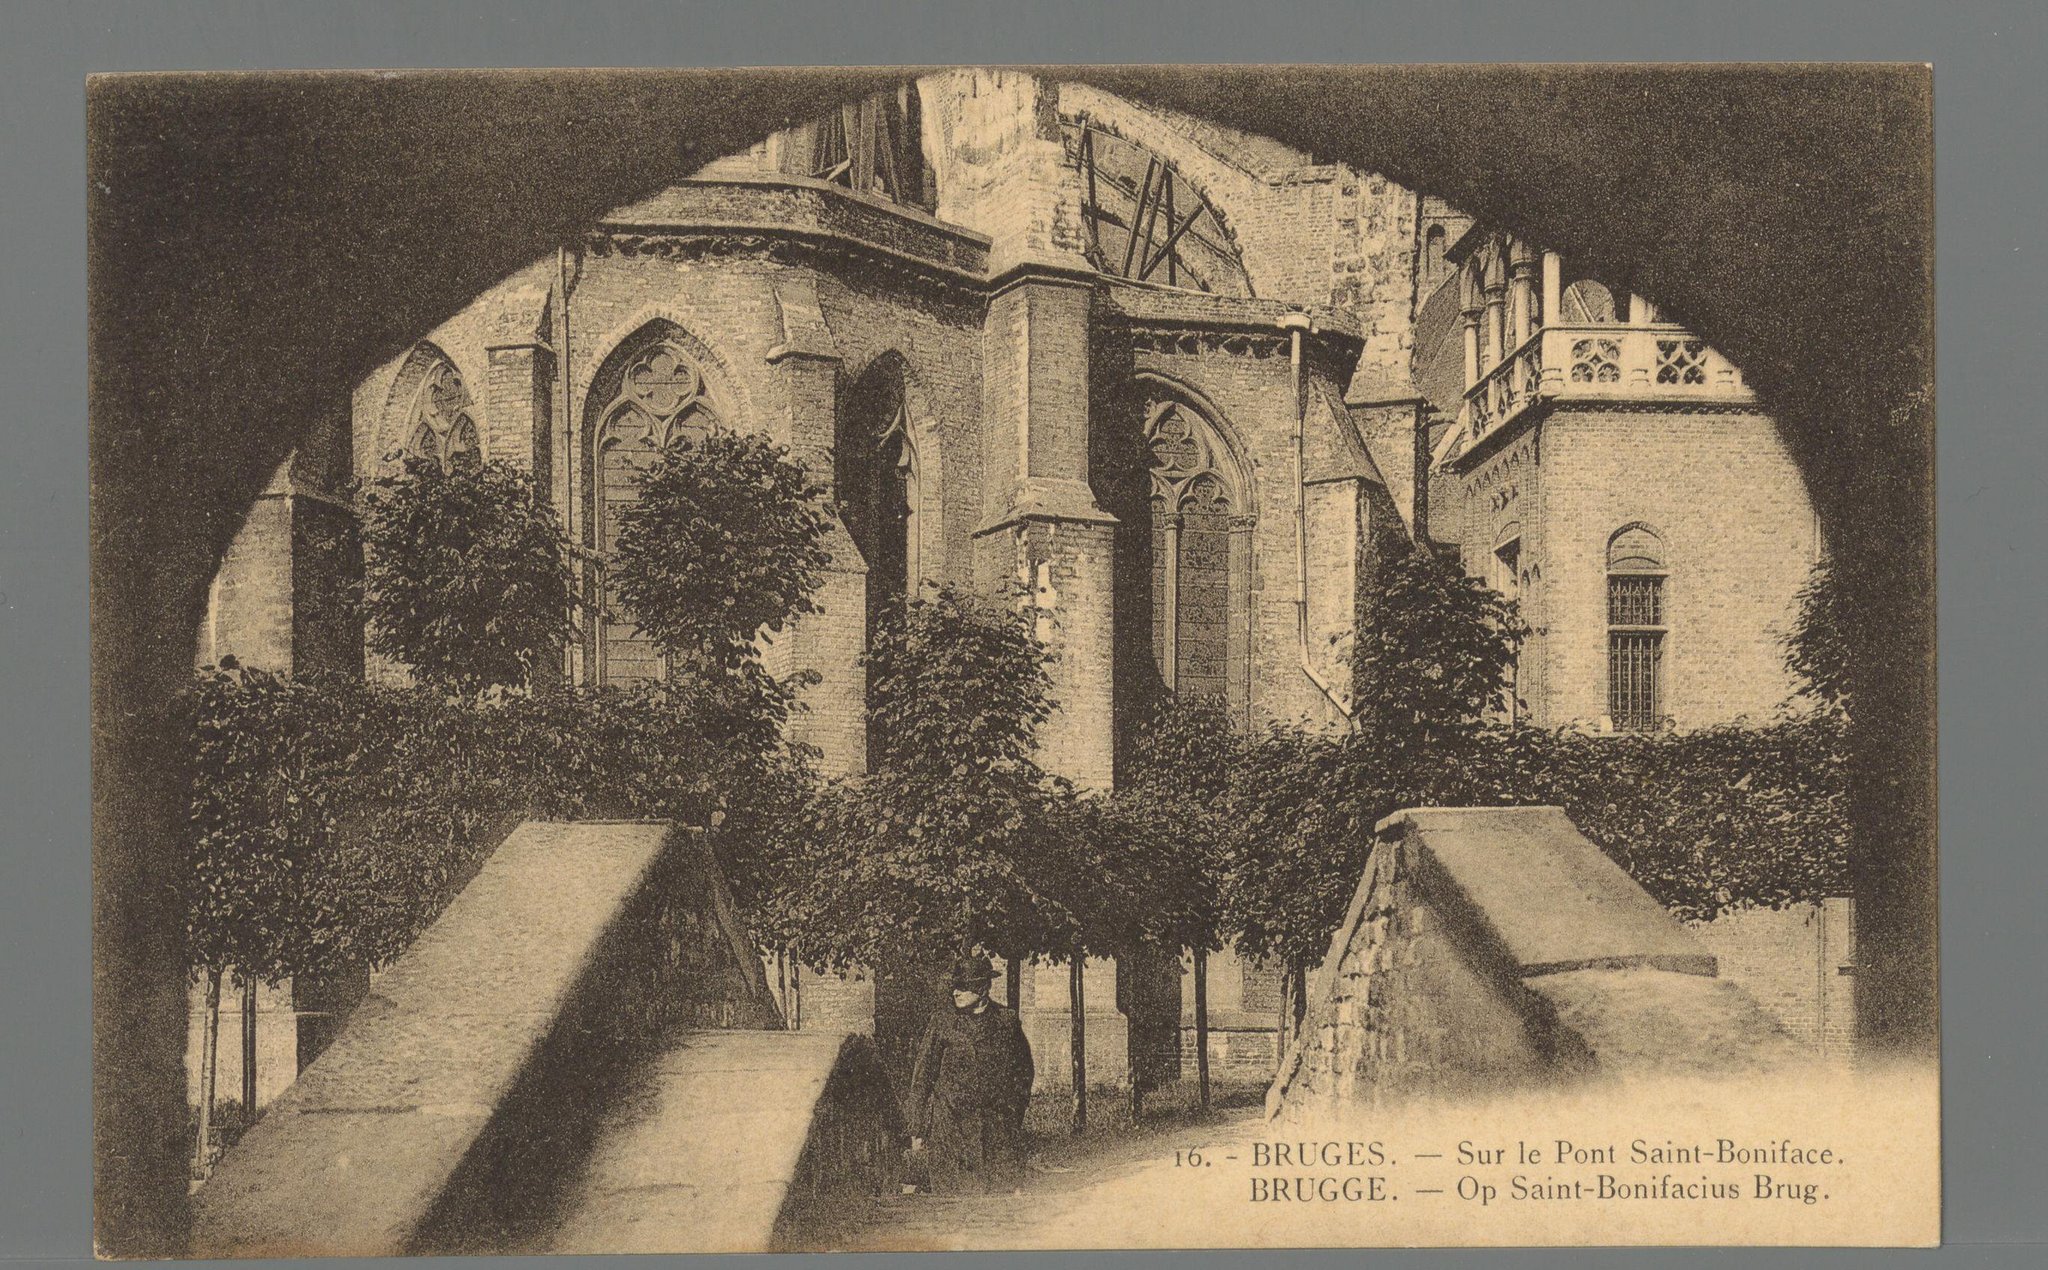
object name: photomechanical print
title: Bruges. Sur le Pont Saint-Boniface / Brugge. Op Saint-Bonifacius Brug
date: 1906-1930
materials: cardboard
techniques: photograph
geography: bruges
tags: church (exterior), bridge, bruges